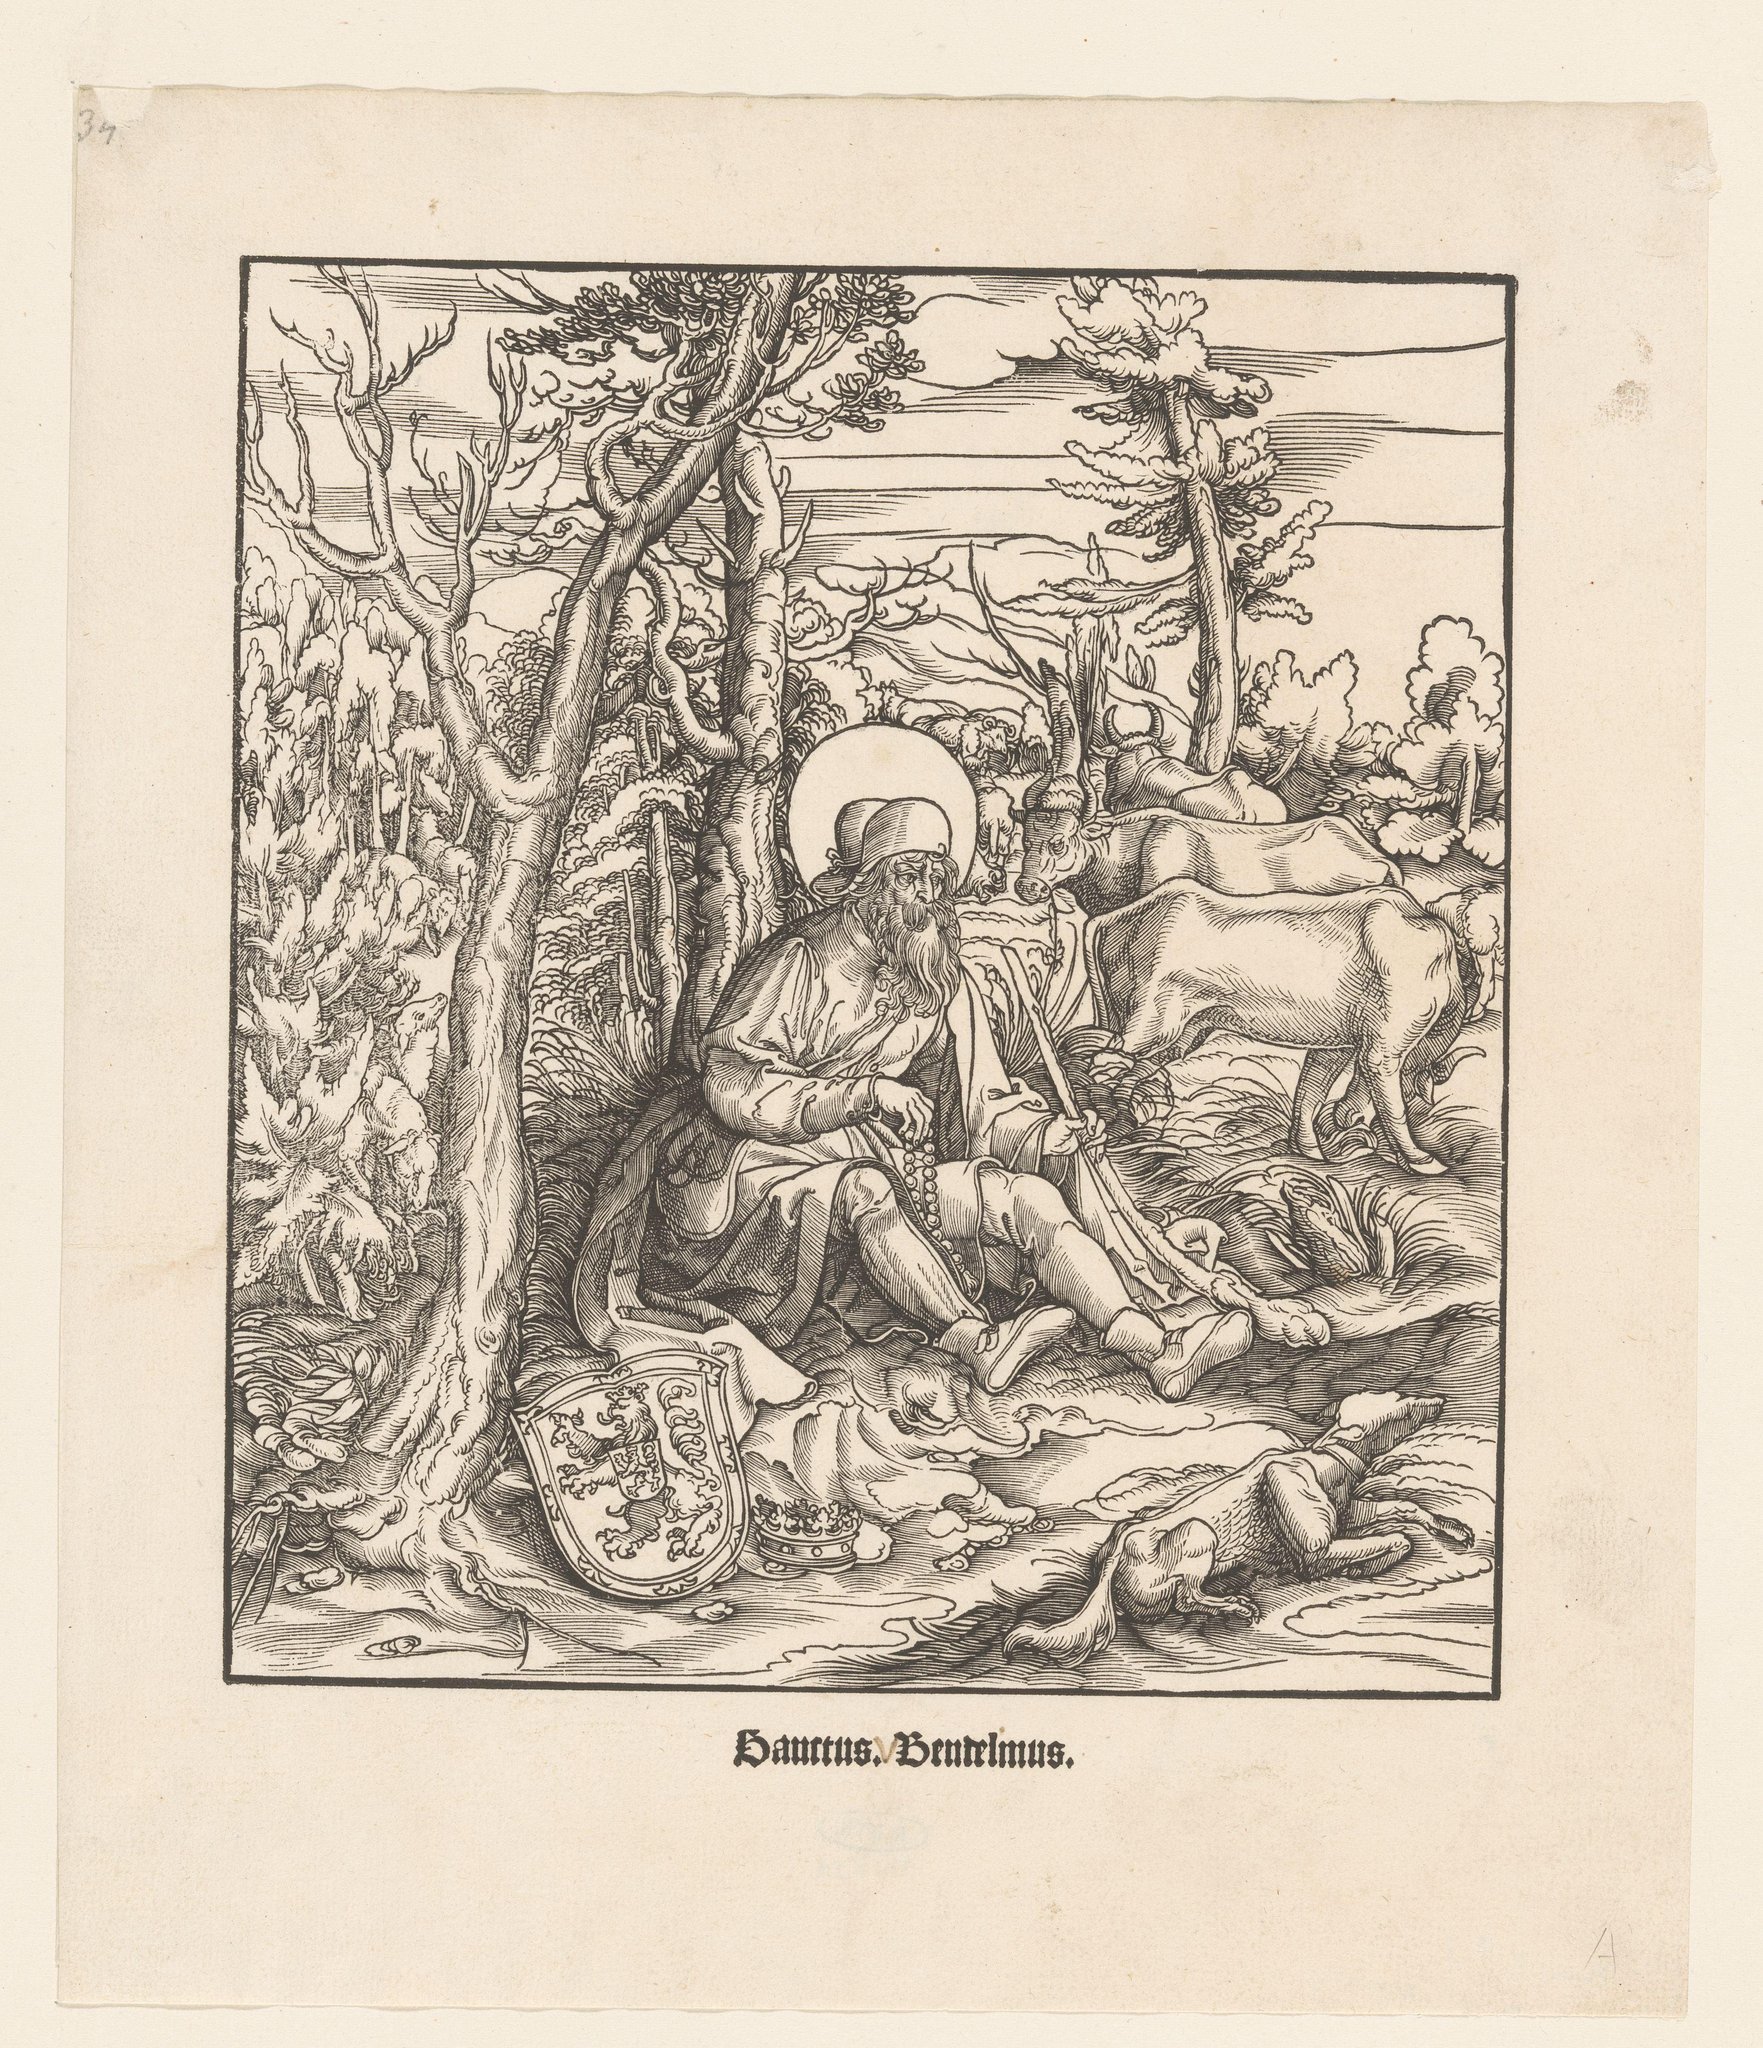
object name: print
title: Heilige Wendelinus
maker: cornelis liefrinck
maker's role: houtsnijder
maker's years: 1517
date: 1516-1518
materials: paper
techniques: woodcut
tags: herding, herdsman, herdswoman, shepherd, shepherdess, cowherd, etc., saints, armorial bearing, heraldry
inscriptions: : ‘V’, collector's mark: Lugt 2228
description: Onderdeel van een serie van 123 houtsnedes met heiligen.